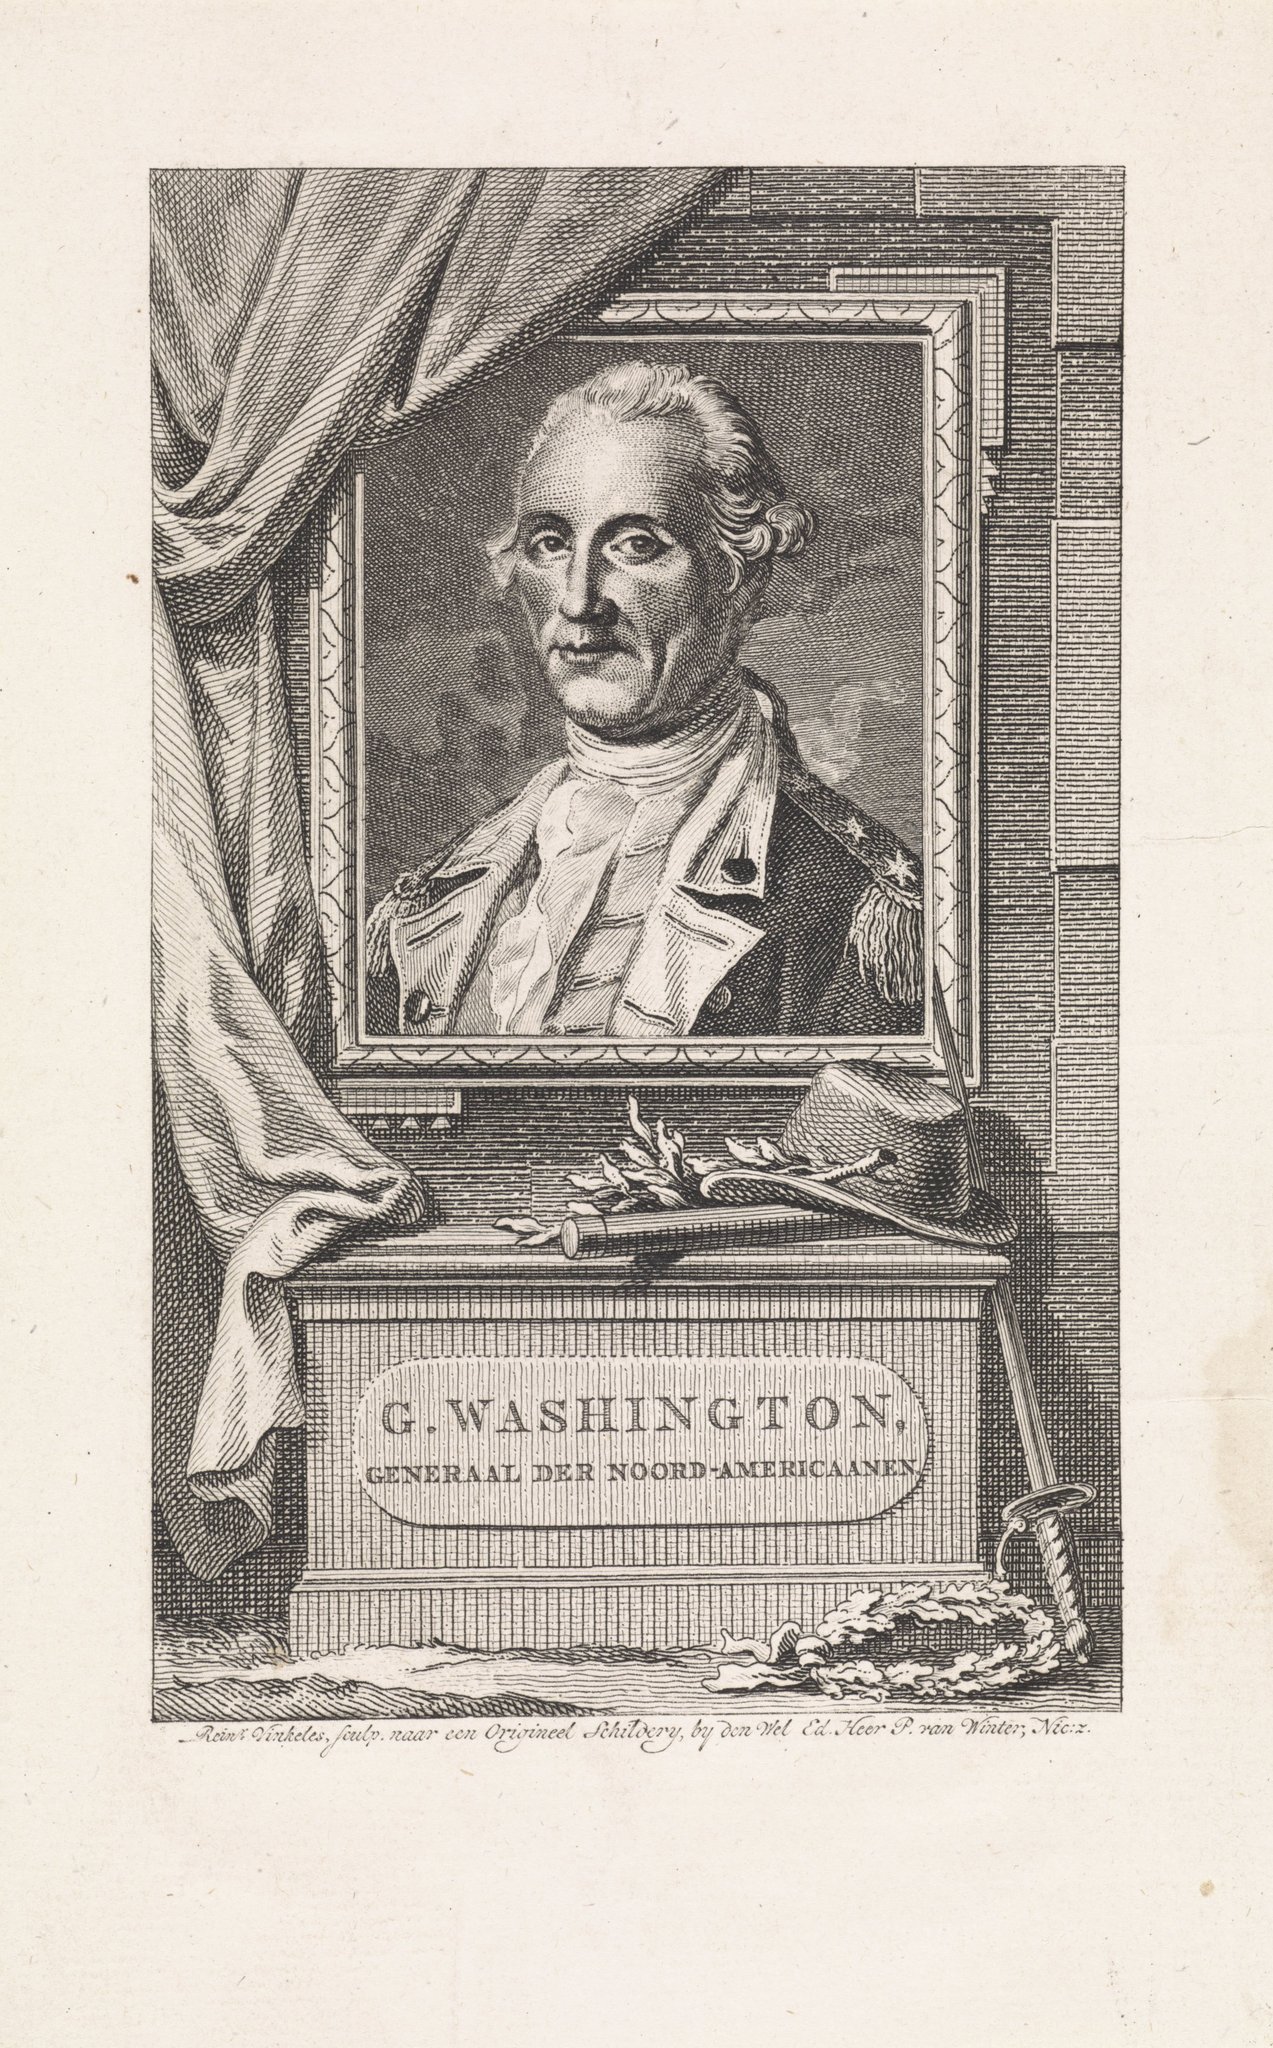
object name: print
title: Portret van George Washington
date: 1786-1809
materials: paper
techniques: engraving, etching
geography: amsterdam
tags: virginia, mount vernon, president, george washington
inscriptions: collector's mark: Lugt 2228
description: Prent ook gebruikt als boekillustratie in: Wagenaar, Jan. Vaderlandsche historie, (...) ten vervolge van Wagenaars Vaderlandsche historie. Dl. 1-43. Amsterdam: Johannes Allart, 1786-1809.